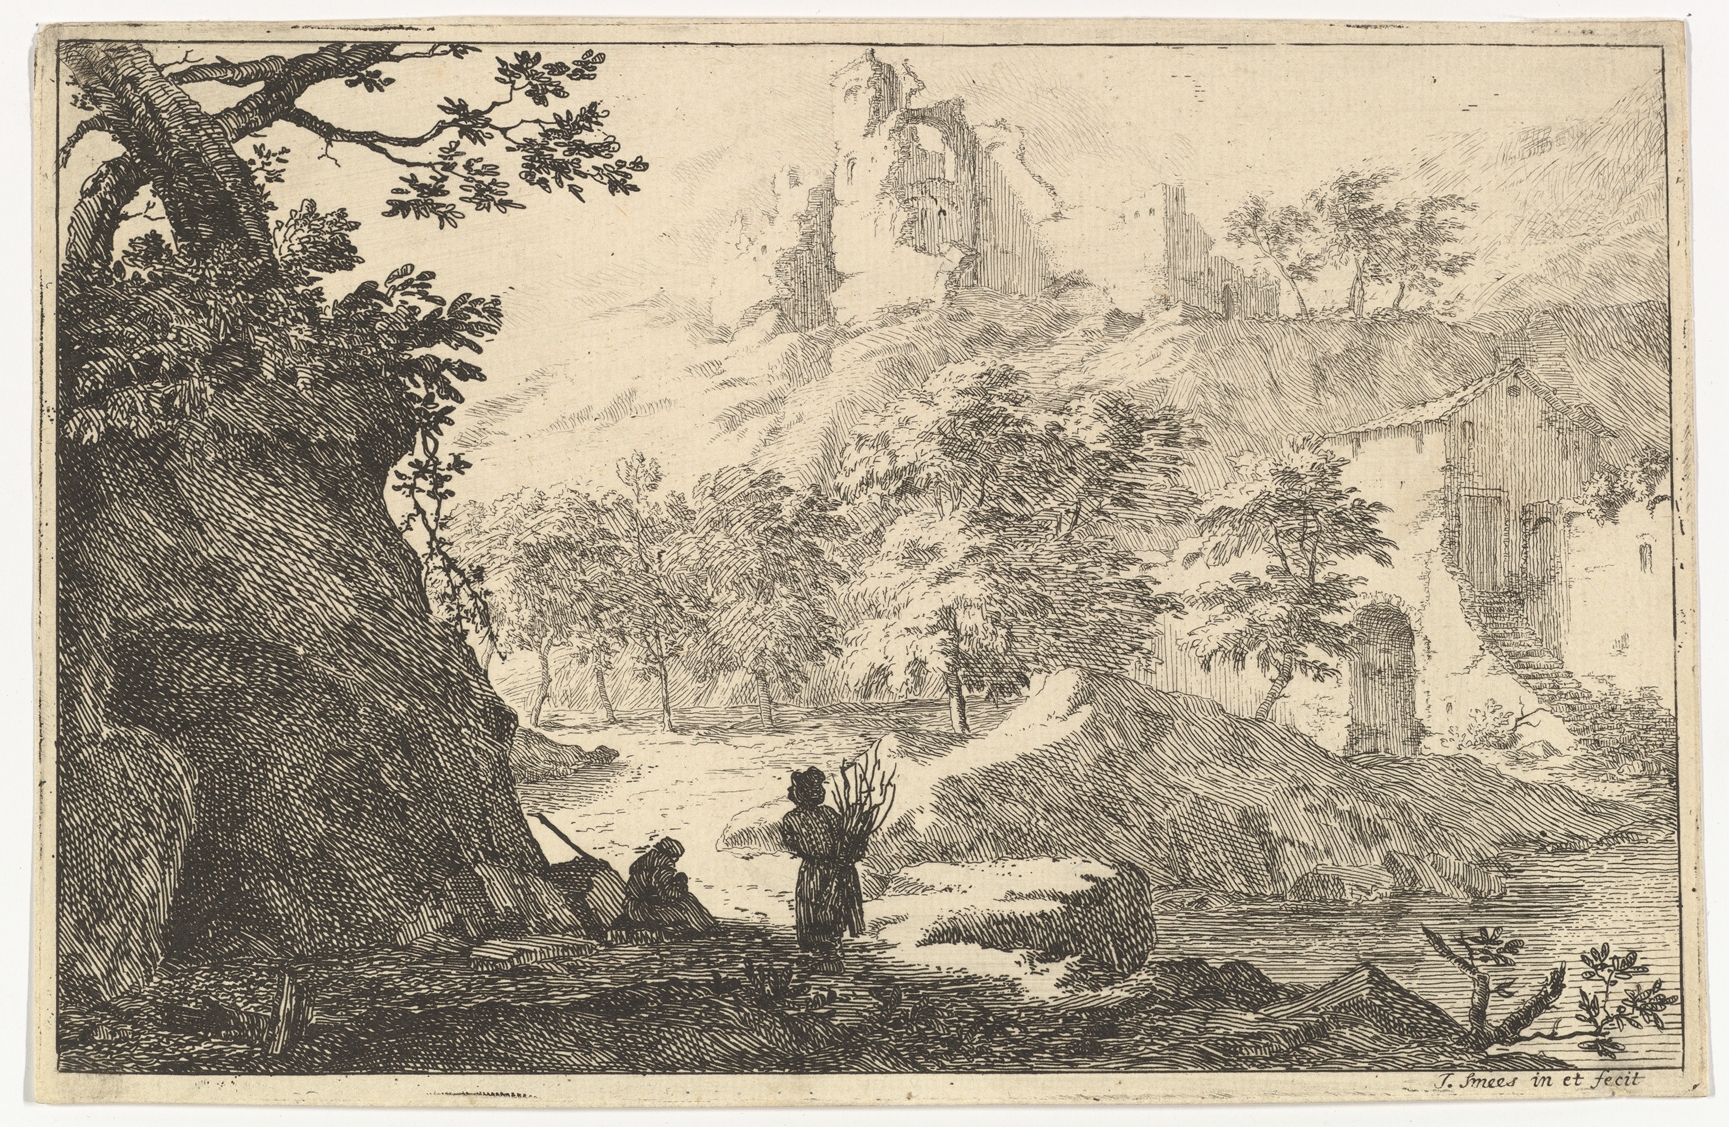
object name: print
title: Landscape with Ruins of a Castle on a Hill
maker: jan smees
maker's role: artist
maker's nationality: dutch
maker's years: 1705-1729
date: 1701-1733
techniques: etching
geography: netherlands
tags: human figures,castles,ruins,hills,landscapes